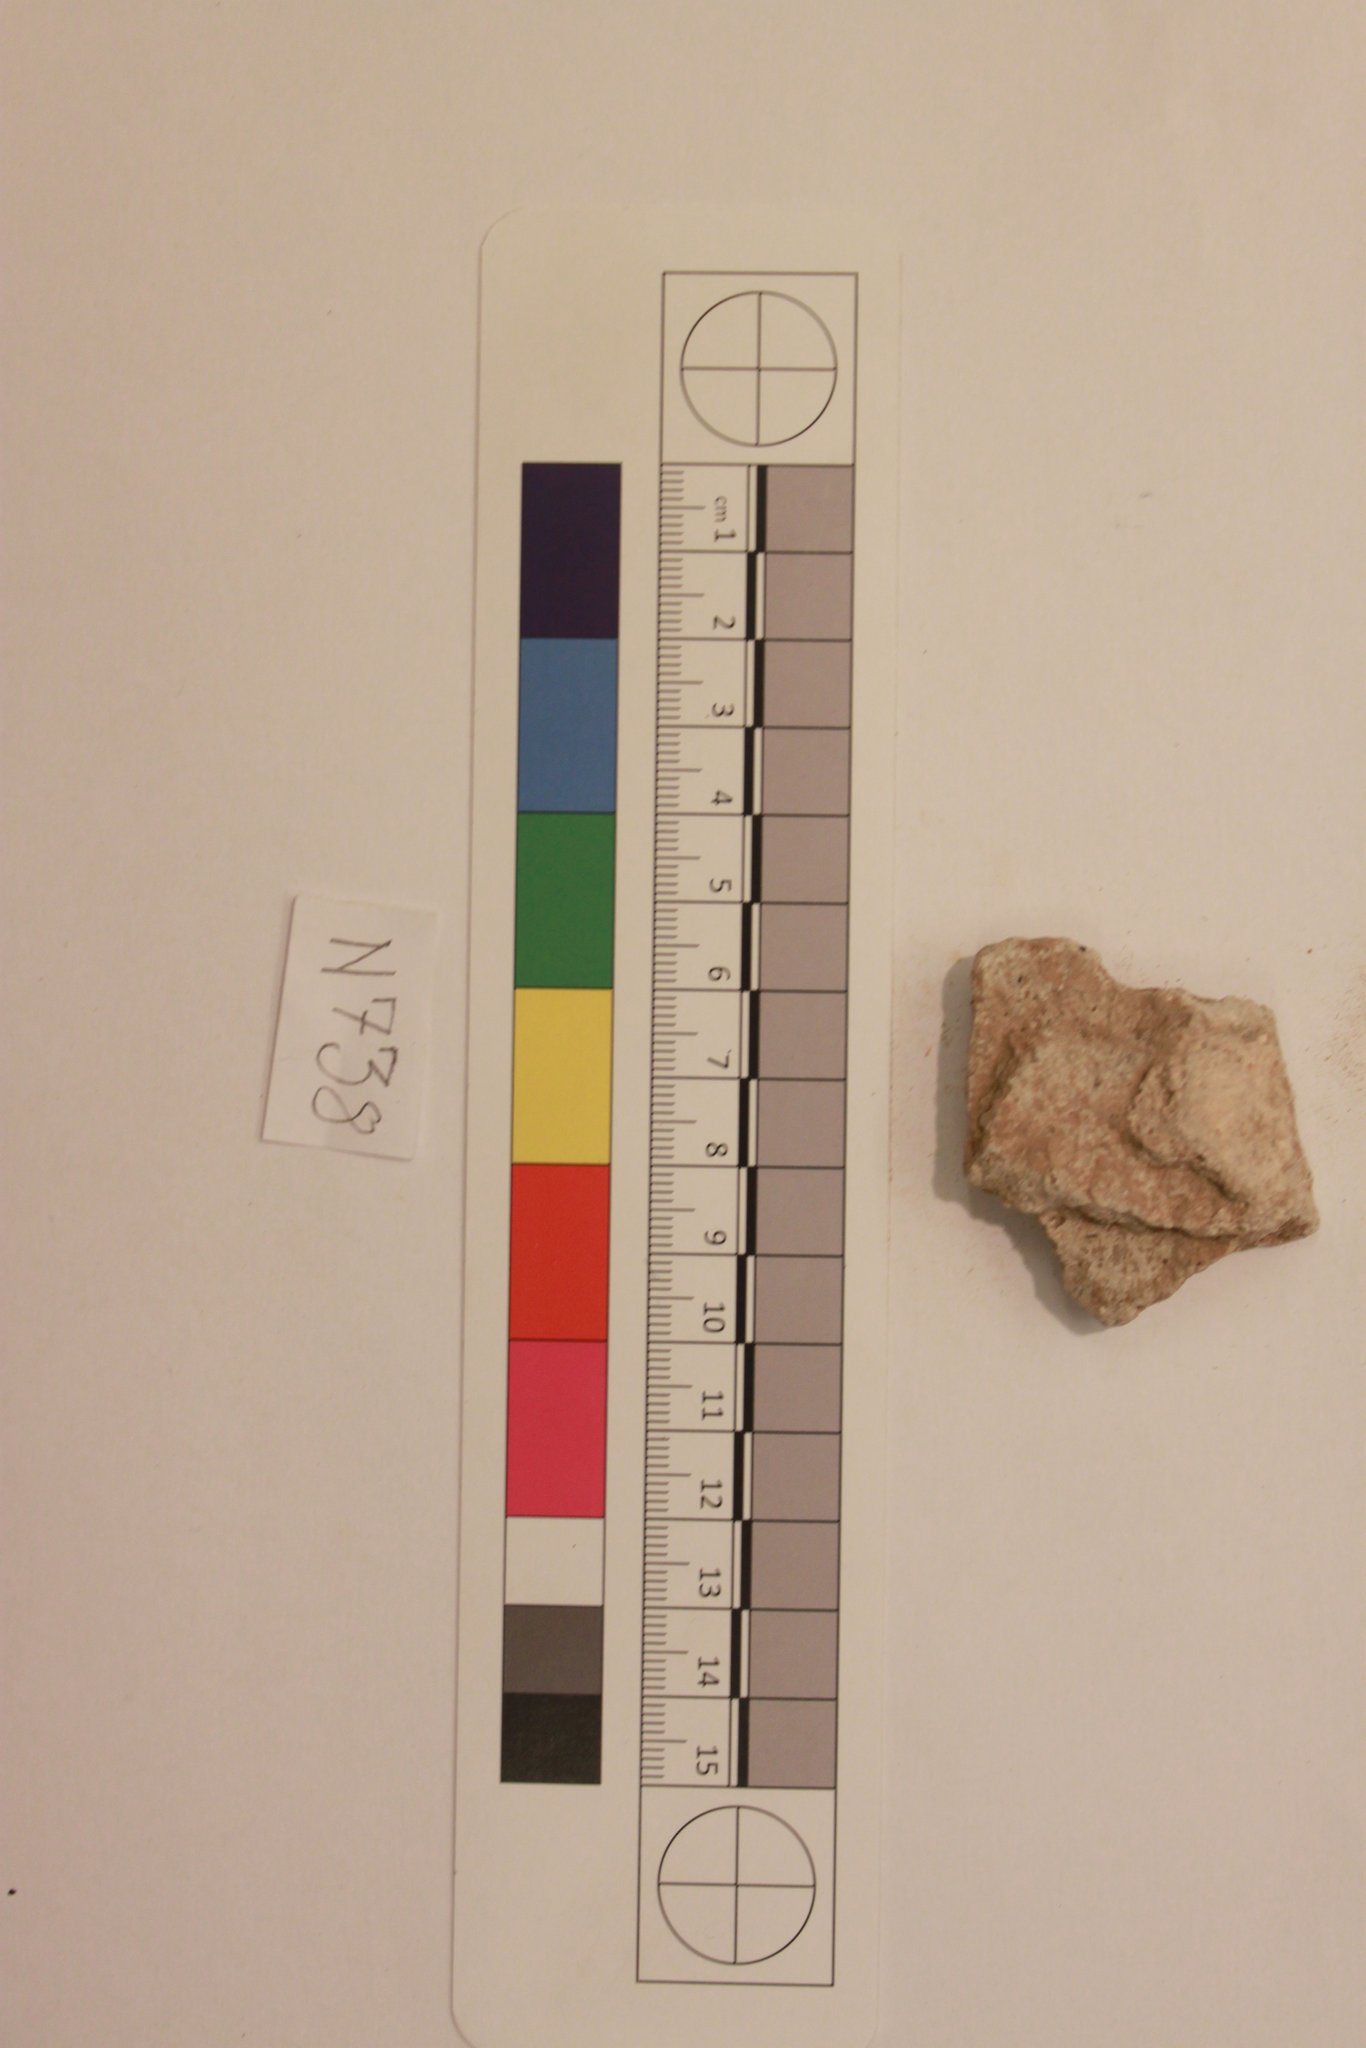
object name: fragment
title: Stucco Fragment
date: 701-1200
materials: plaster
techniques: carving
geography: iran